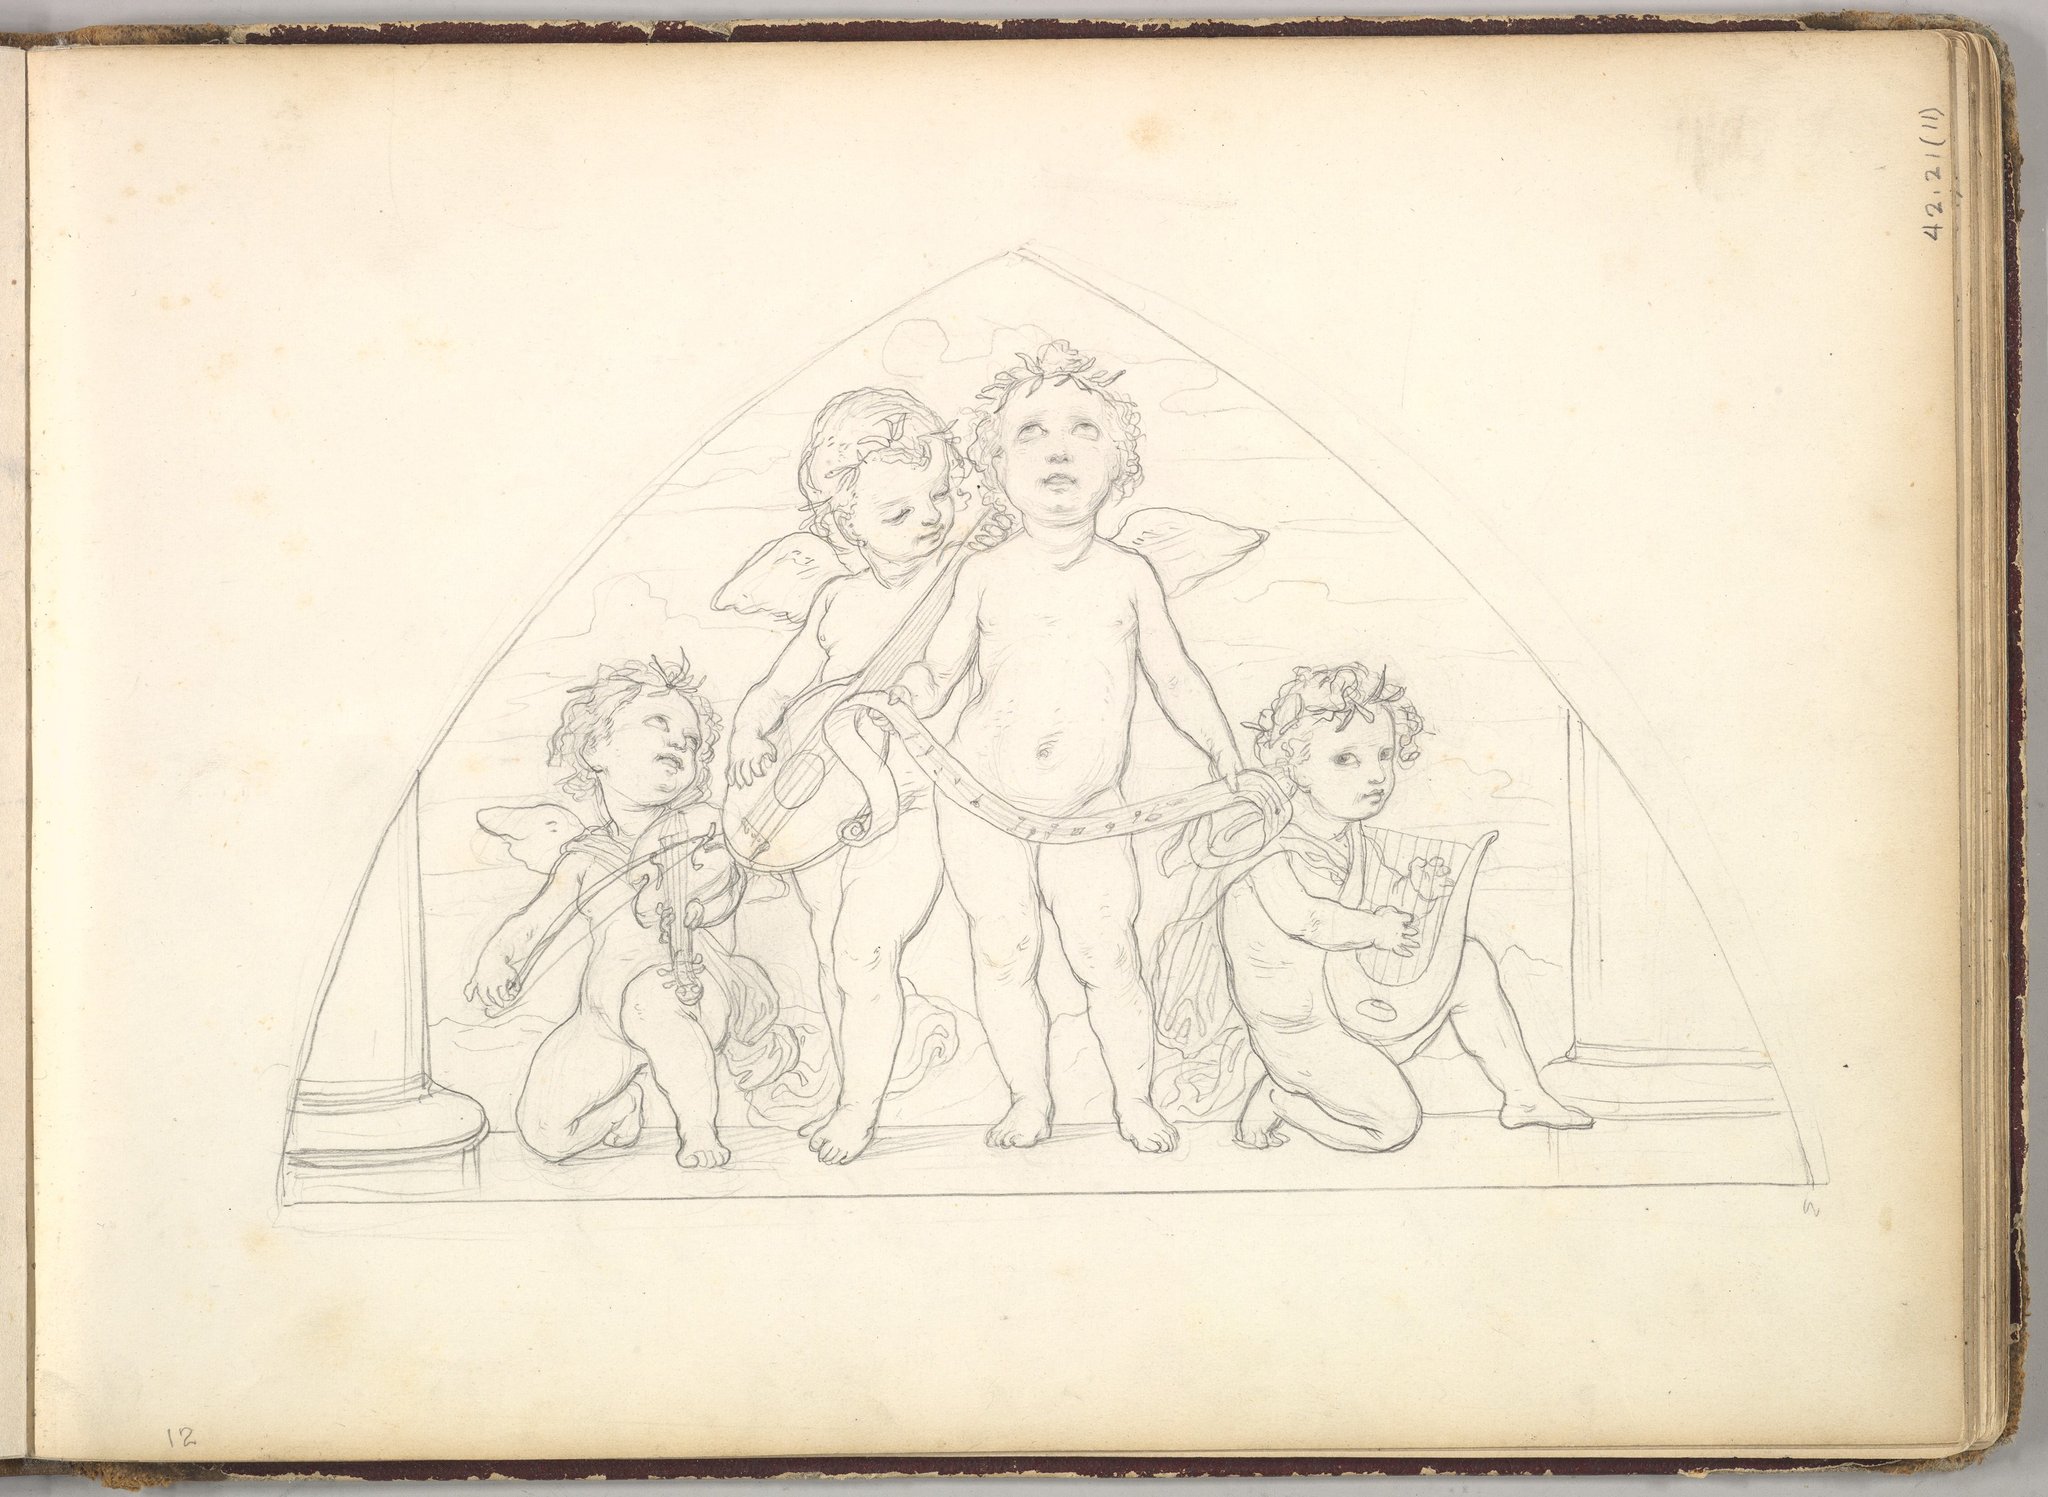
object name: drawing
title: Four Musical Putti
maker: frederic, lord leighton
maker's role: artist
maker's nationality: british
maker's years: 1830-1896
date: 1849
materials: graphite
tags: musical instruments,violins